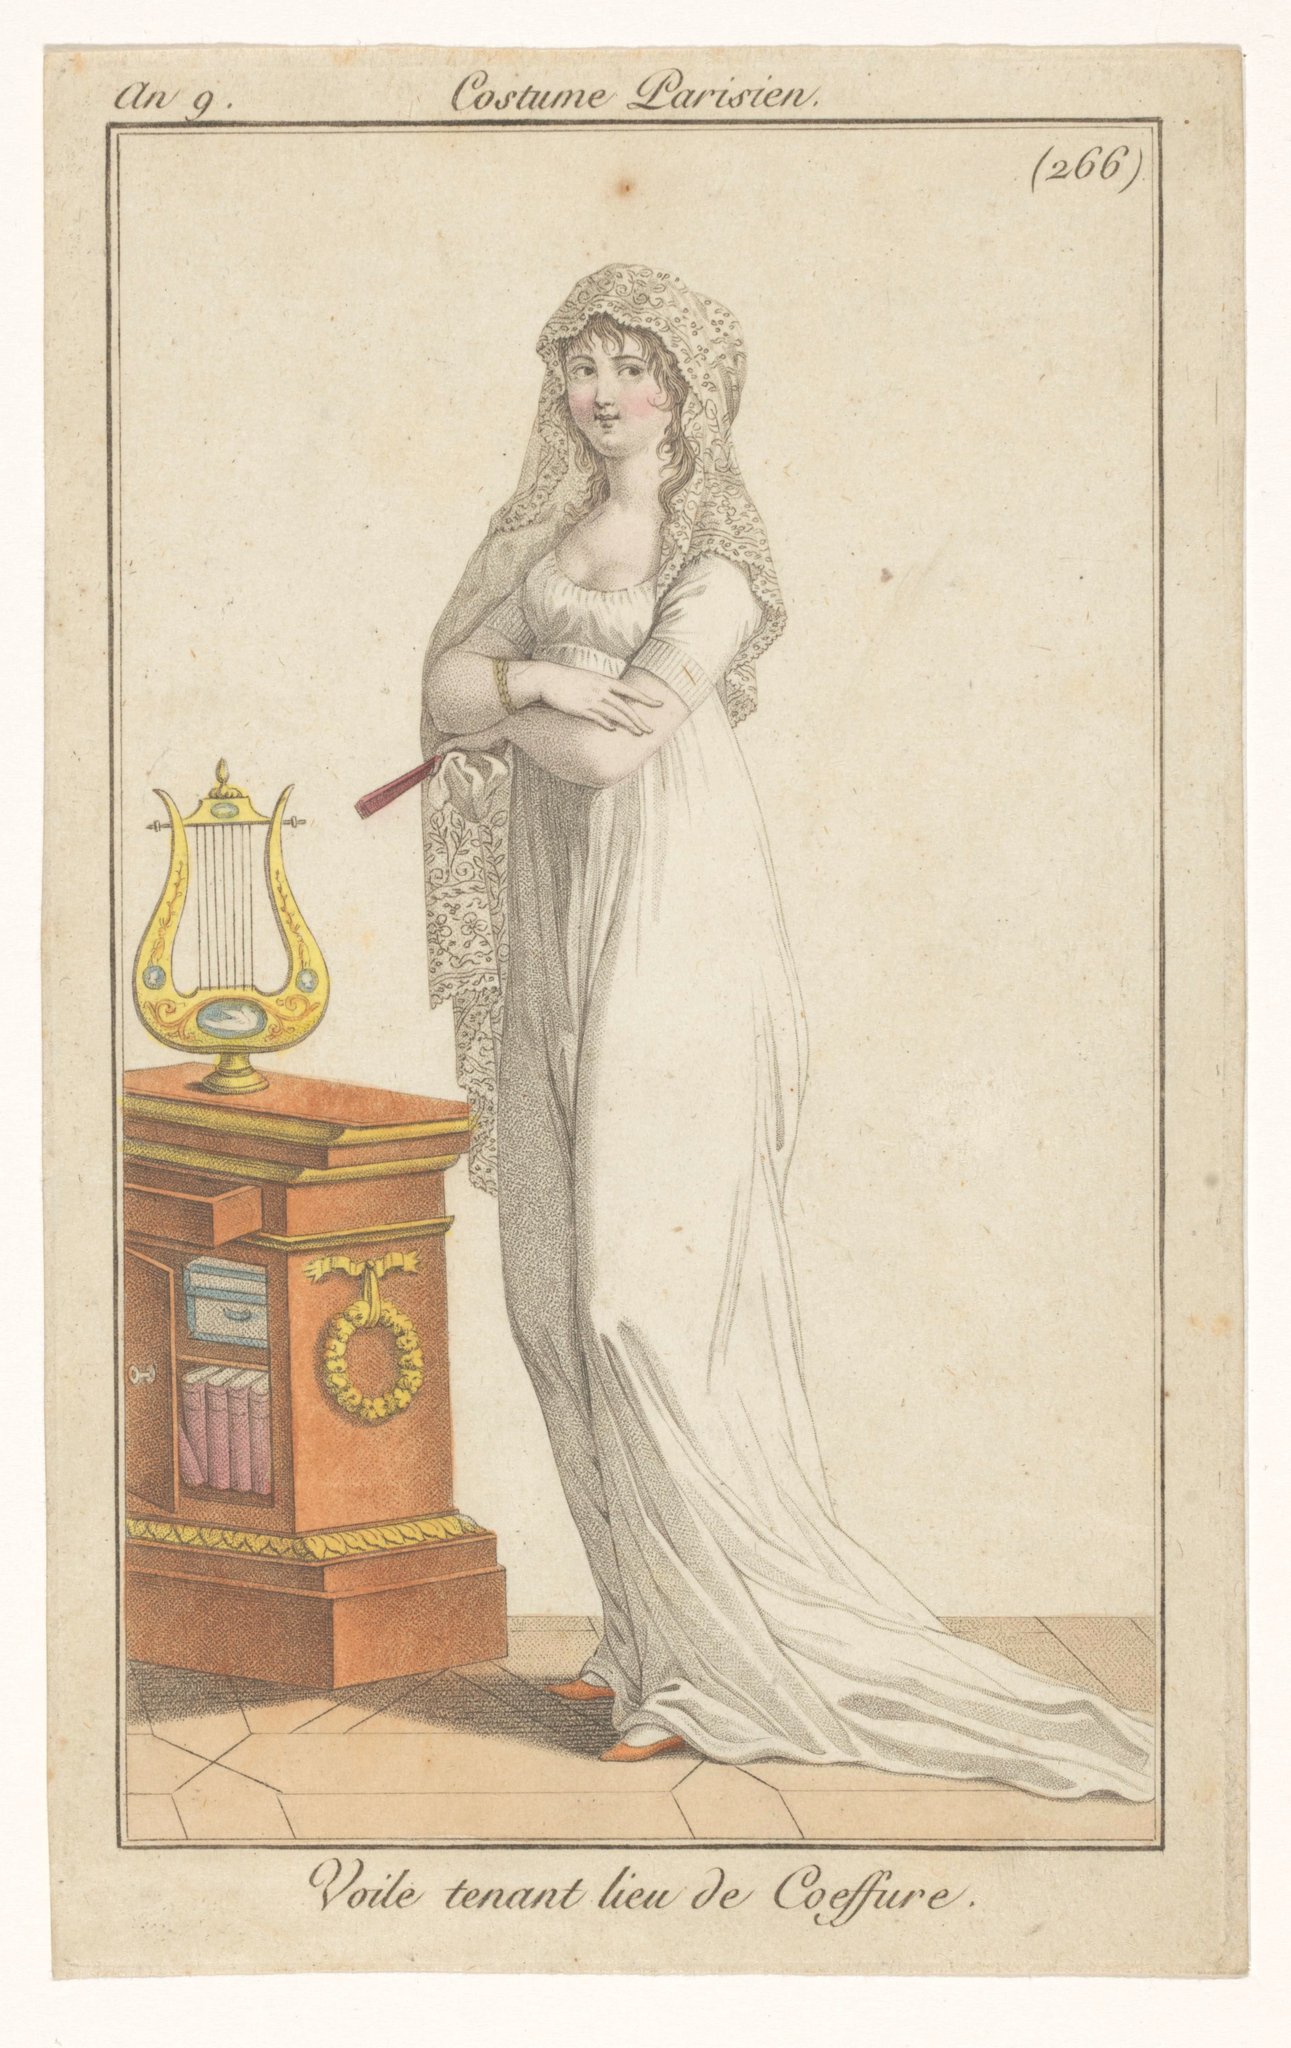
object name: fashion print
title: Volie tenant lieu de Coeffure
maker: Anonymous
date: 1800-1801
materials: paper, ink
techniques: etching, hand coloring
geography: france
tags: fashion plates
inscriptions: collector's mark: Lugt 2228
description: Jonge vrouw met sluier, staande bij een kastje waarop een lier staat. Prent genomen uit het modetijdschrift Journal des Dames et des Modes, Costume Parisien, An 9 [1800-1801], nr. 266.